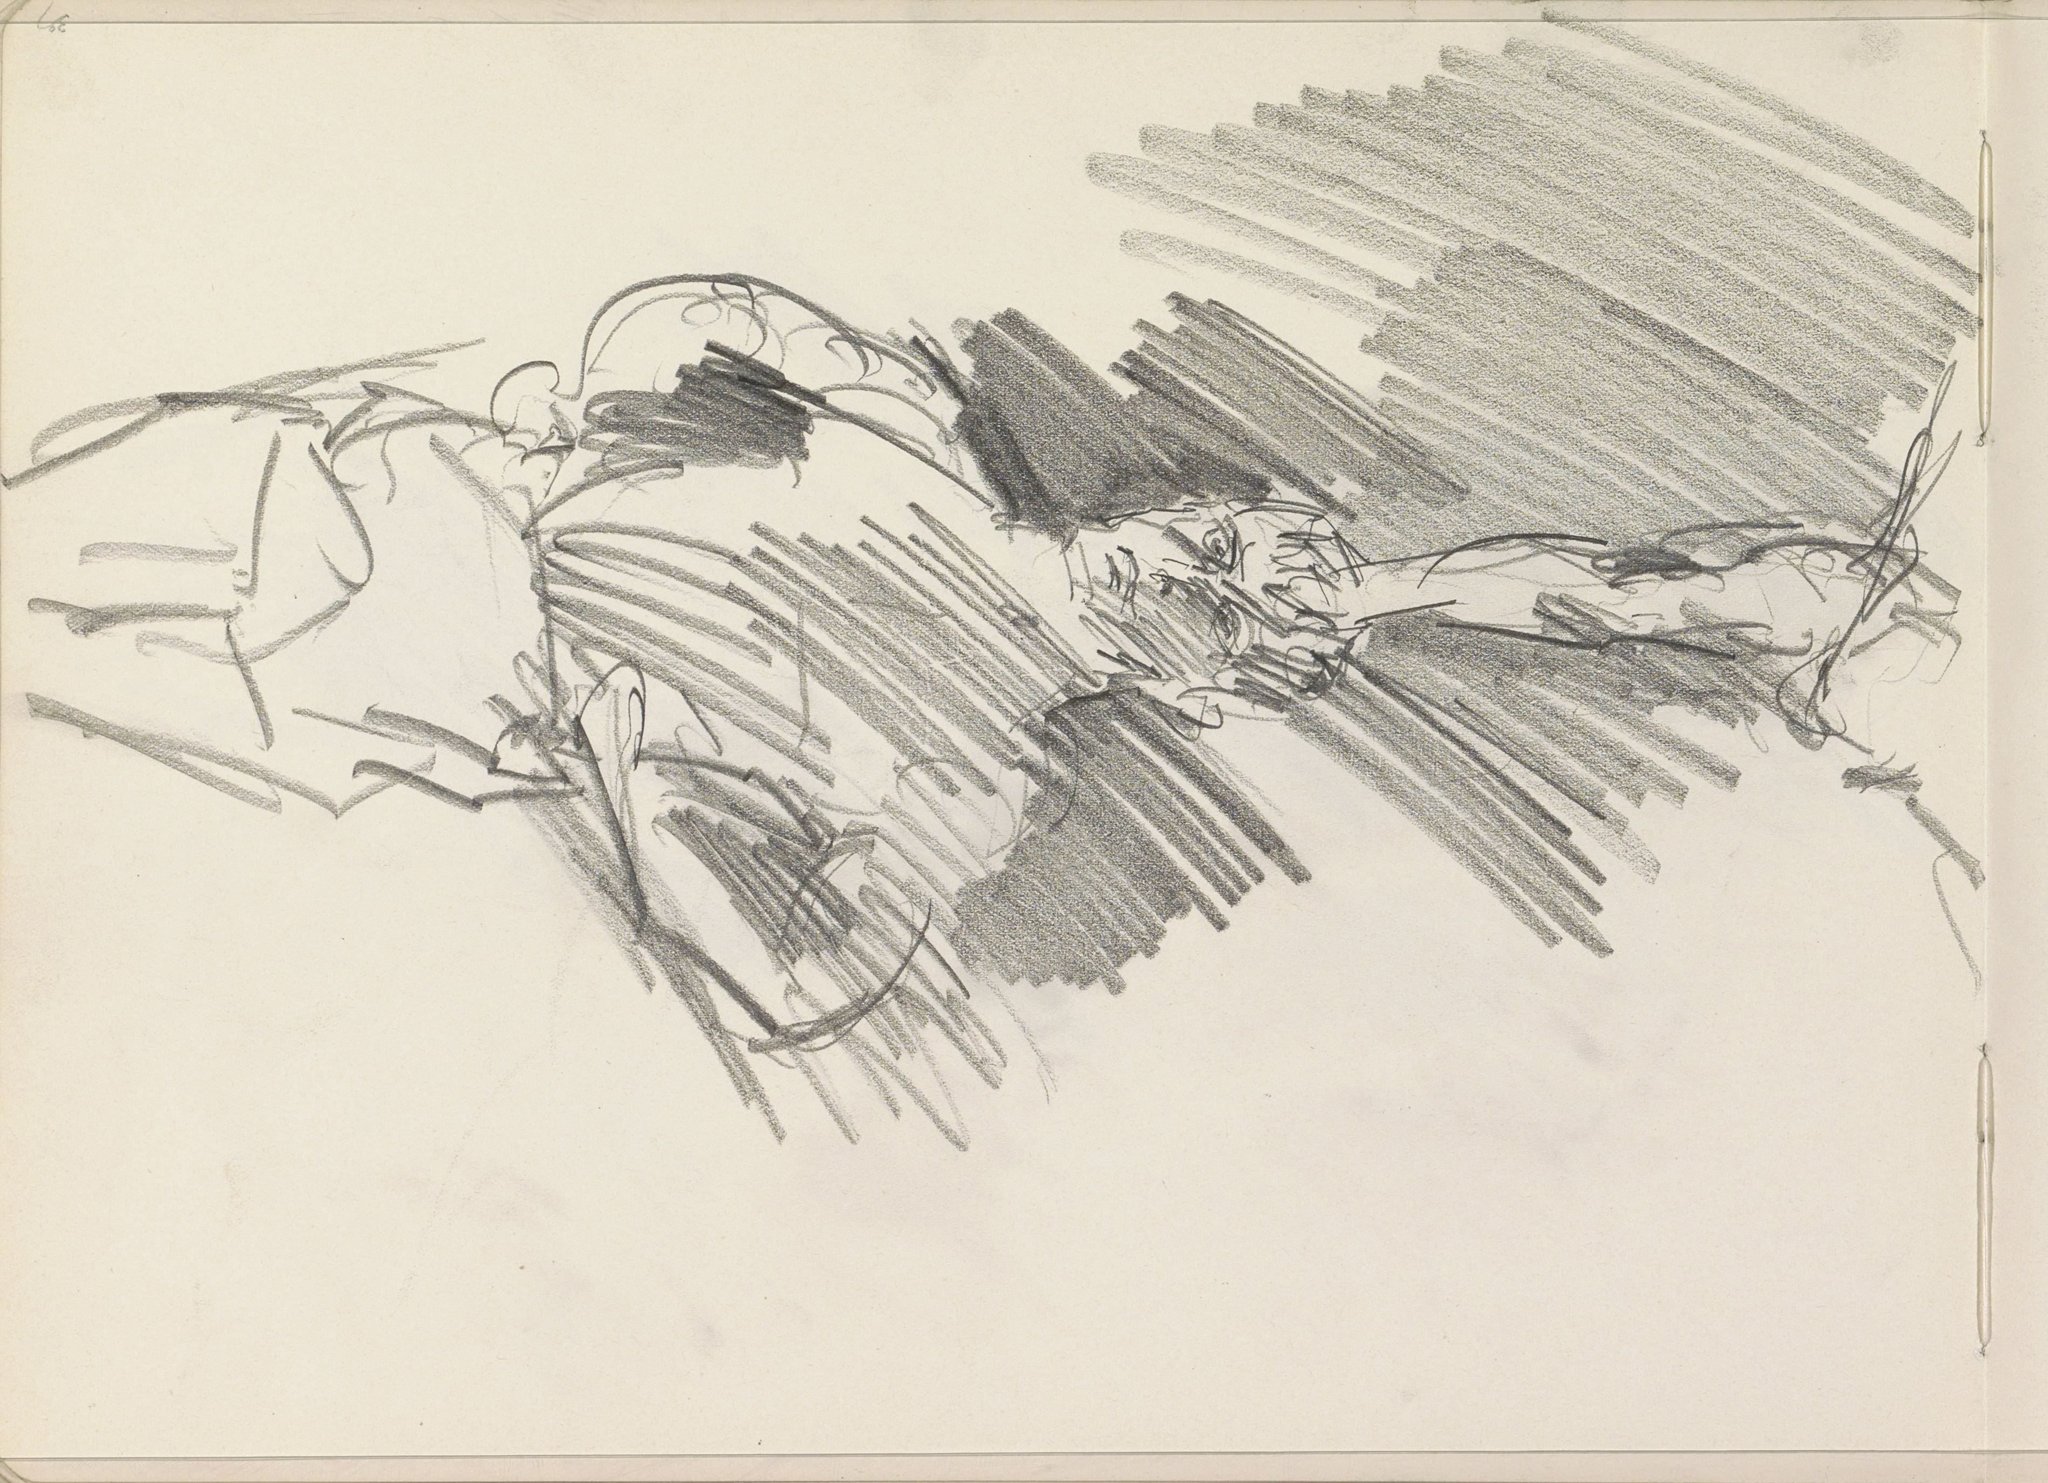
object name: sketchbook leaf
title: Acrobaat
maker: isaac israels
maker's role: draughtsman, painter, print maker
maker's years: 1865-1934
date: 1875-1934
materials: paper, pencil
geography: the hague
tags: acrobat ~ circus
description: Een acrobaat, alleen een arm is zichtbaar, maakt op één hand een handstand op het hoofd van een andere acrobaat. Blad 30 verso uit schetsboek V met 33 bladen.